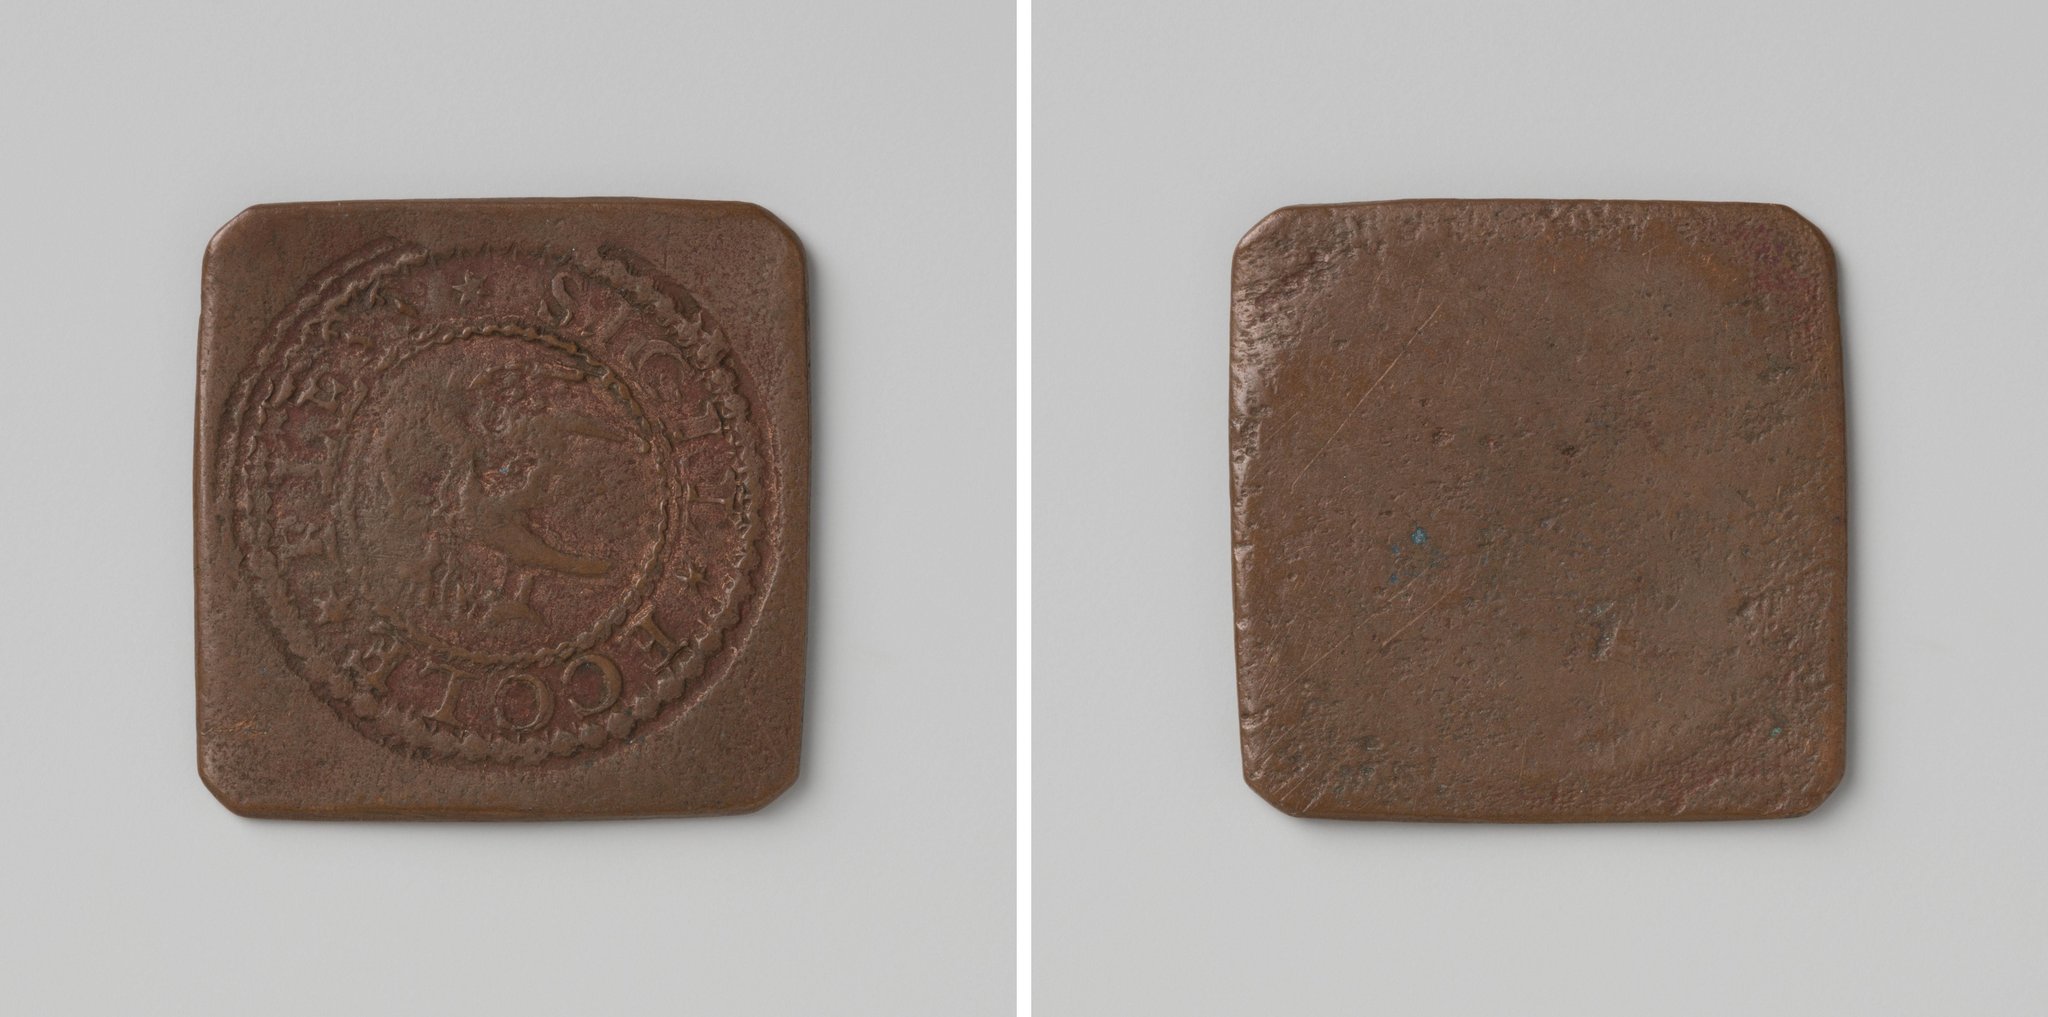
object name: devotional medal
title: Zegel van de Waalse gemeente van Vlissingen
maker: Anonymous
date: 1635-1800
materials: copper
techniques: snipping, striking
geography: flushing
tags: flushing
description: Eenzijdige koperen vierkante penning met afgeschuinde hoeken. Voorzijde: pelikaan die jongen voedt met eigen bloed binnen omschrift. Keerzijde: blanco.